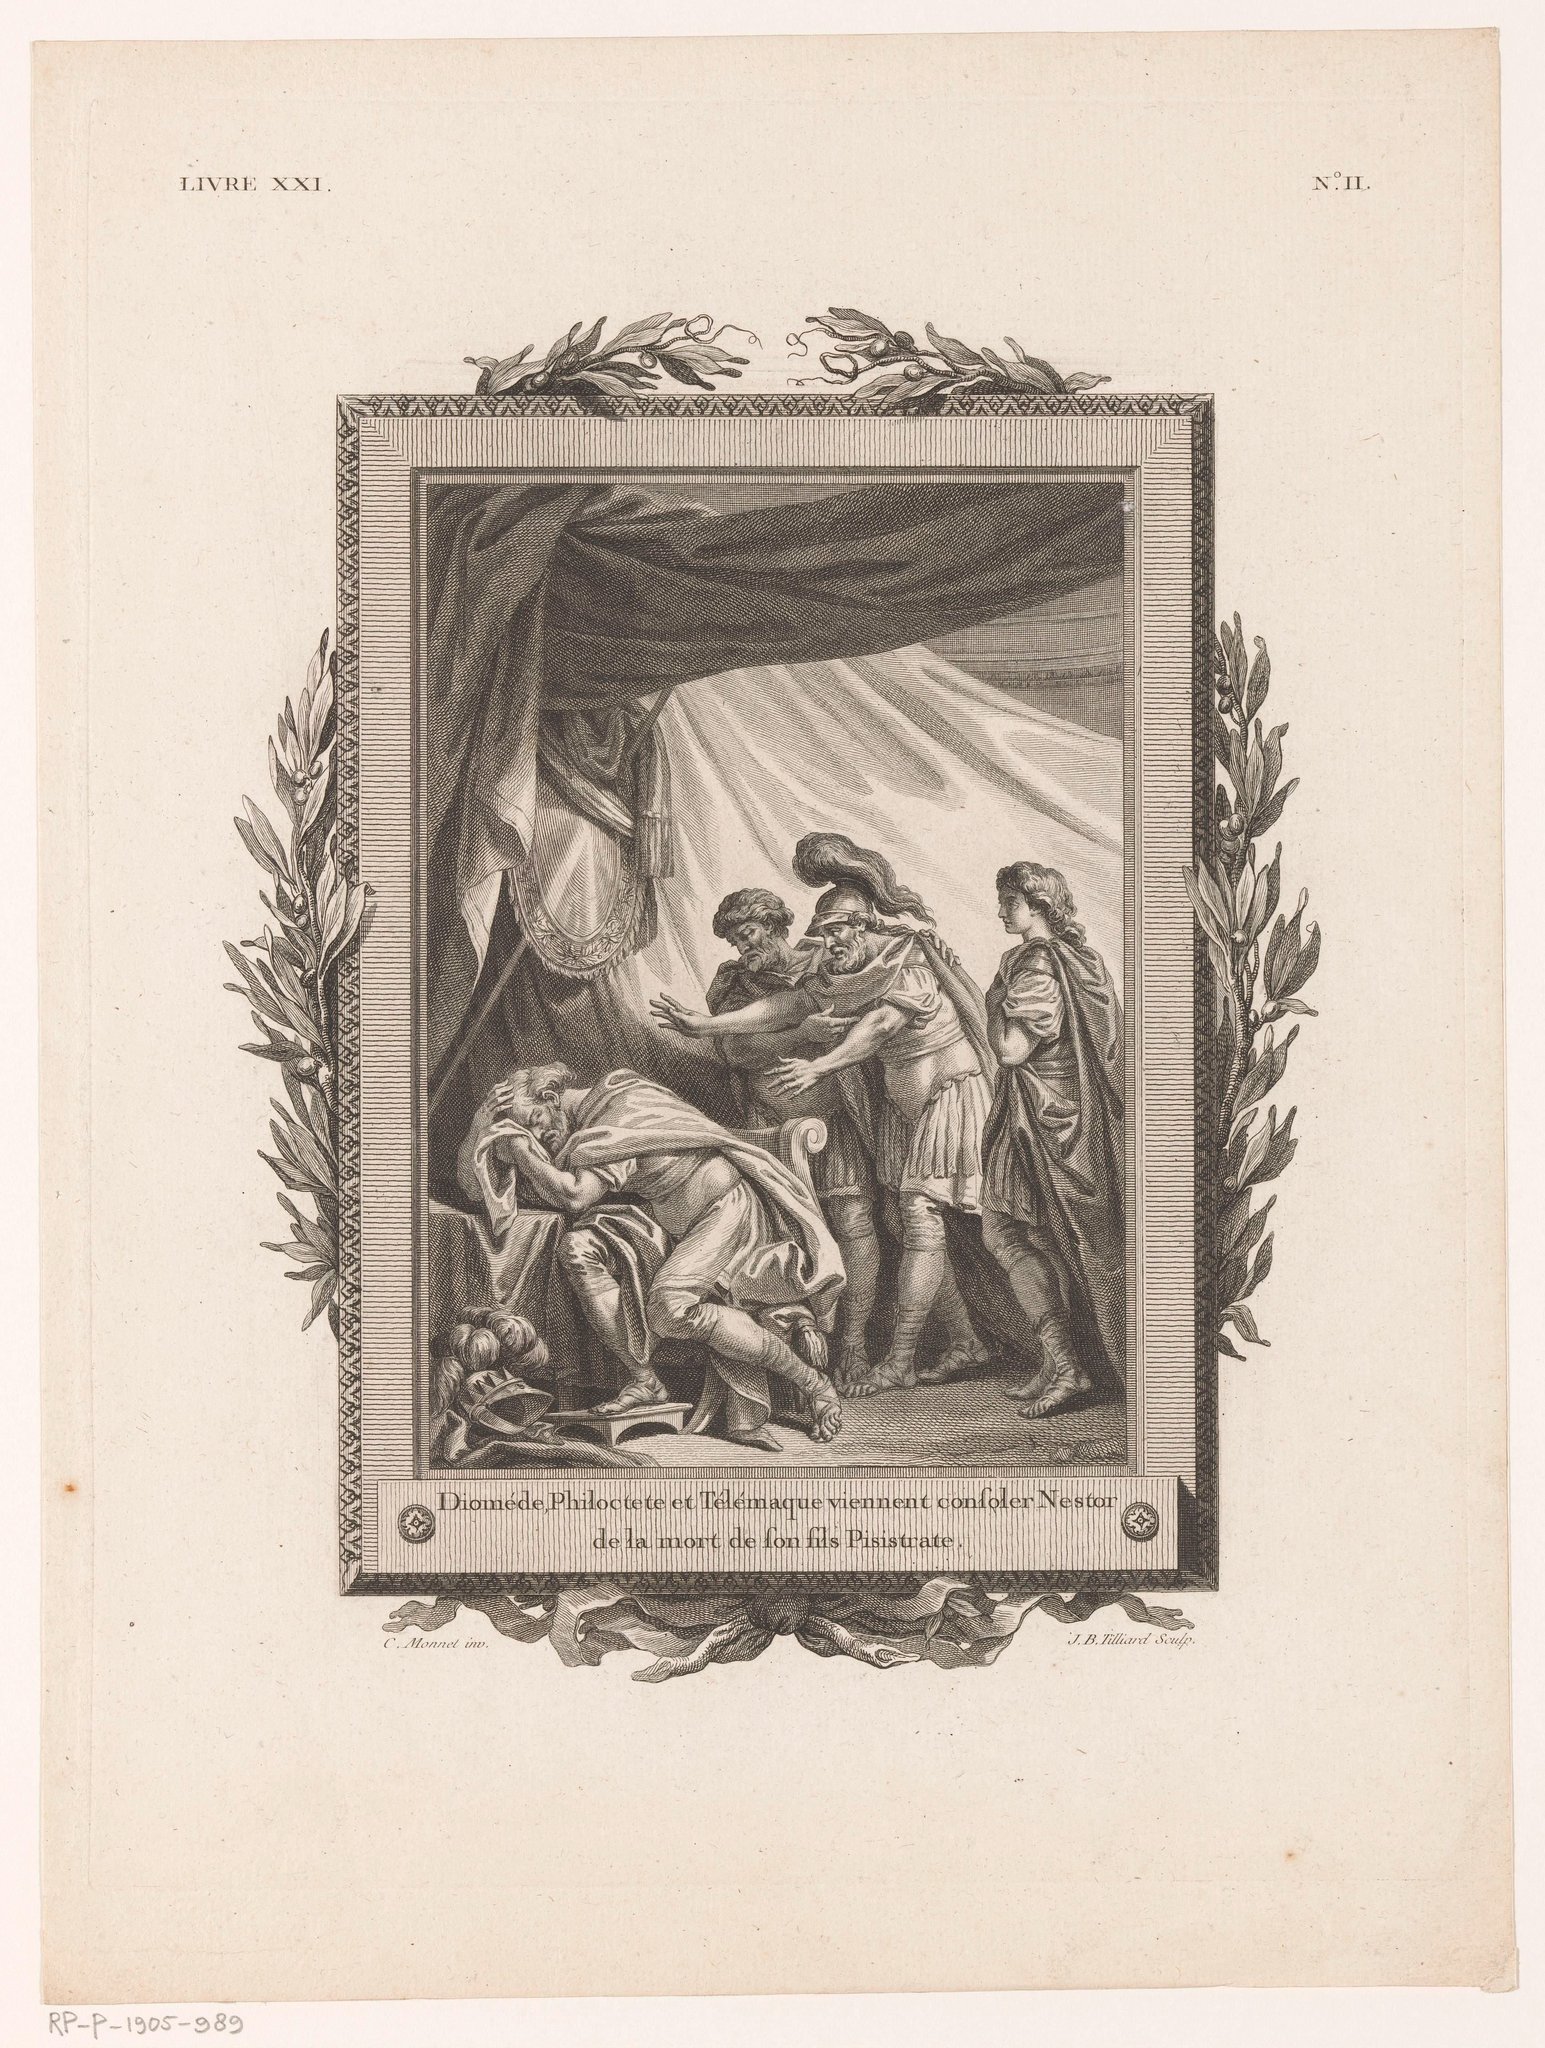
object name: book illustration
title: Telemachus, Philoktetes en Diomedes troosten Nestor na het verlies van zijn zoon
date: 1785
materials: paper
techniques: engraving, etching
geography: paris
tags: (fenelon, telemachus) specific works of literature (with author, title), consolation, (story of) telemachus, ornament ~ festoon, garland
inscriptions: collector's mark: Lugt 2228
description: Nestor, gezeten aan tafel in een tent met zijn hoofd in zijn handen, wordt bezocht door Telemachus, Philoktetes en Diomedes die achter hem de tent binnenlopen. Het geheel wordt gekaderd door een sierlijst met olijftakken en onderaan een strik. Genummerd rechtsboven: No. II.